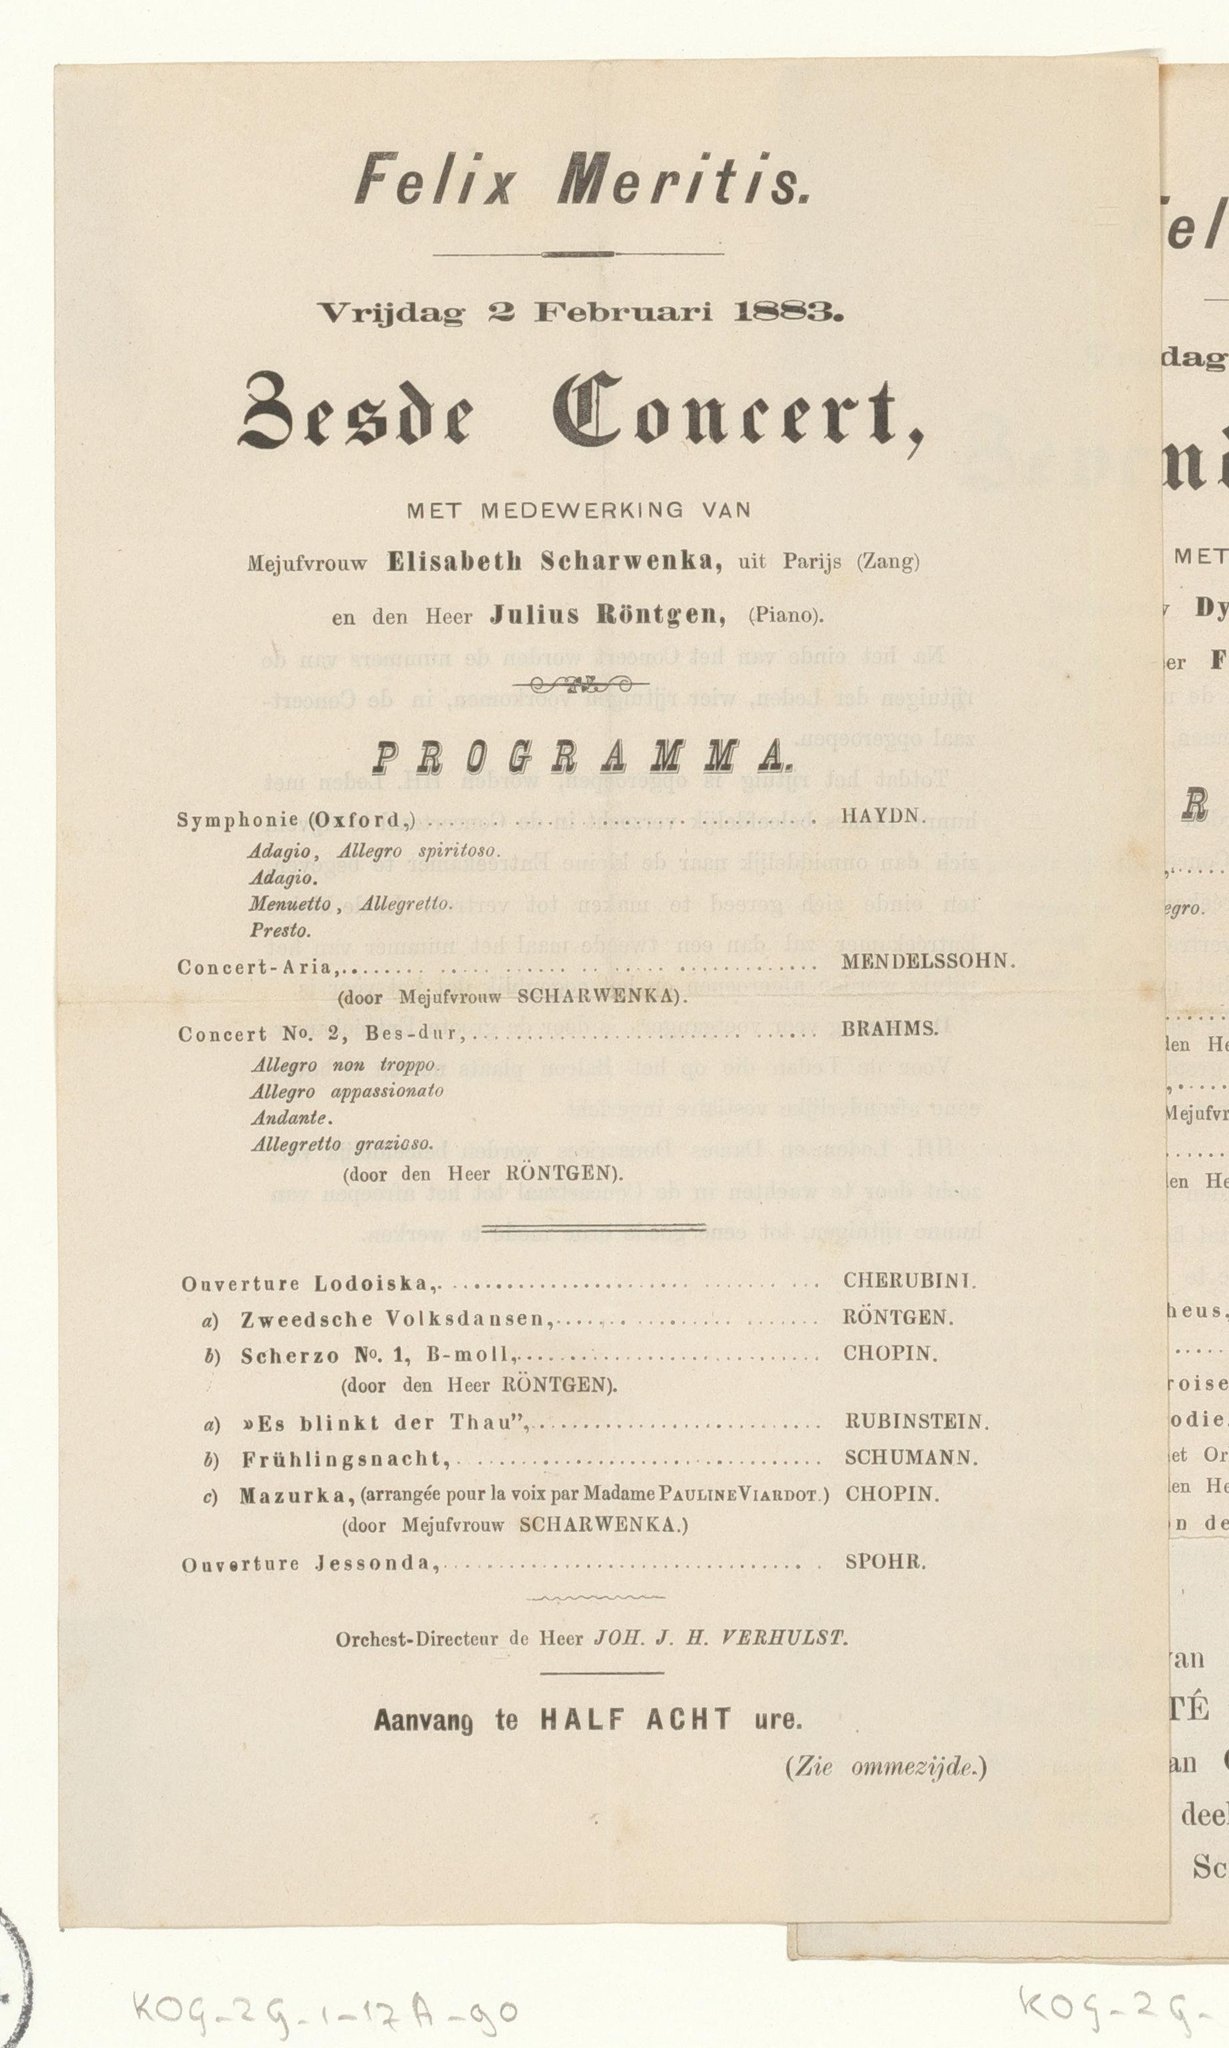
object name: programma, programmaboekje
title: Programma voor een concert in Felix Meritis op 2 februari 1883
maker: Anonymous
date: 1883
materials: paper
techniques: letterpress printing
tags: the hague, johannes verhulst, listening to music, large group of musicians, orchestra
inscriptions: collector's mark: Lugt 1641, collector's mark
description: Gedrukt programma voor het Vierde Concert door het orkest onder leiding van Johannes Verhulst, in Felix Meritis te Amsterdam op 2 februari 1883. Onderwerpsrubrieken binnen de Atlas Zeden en Gewoonten: Muziek en muziekinstrumenten: Varia.